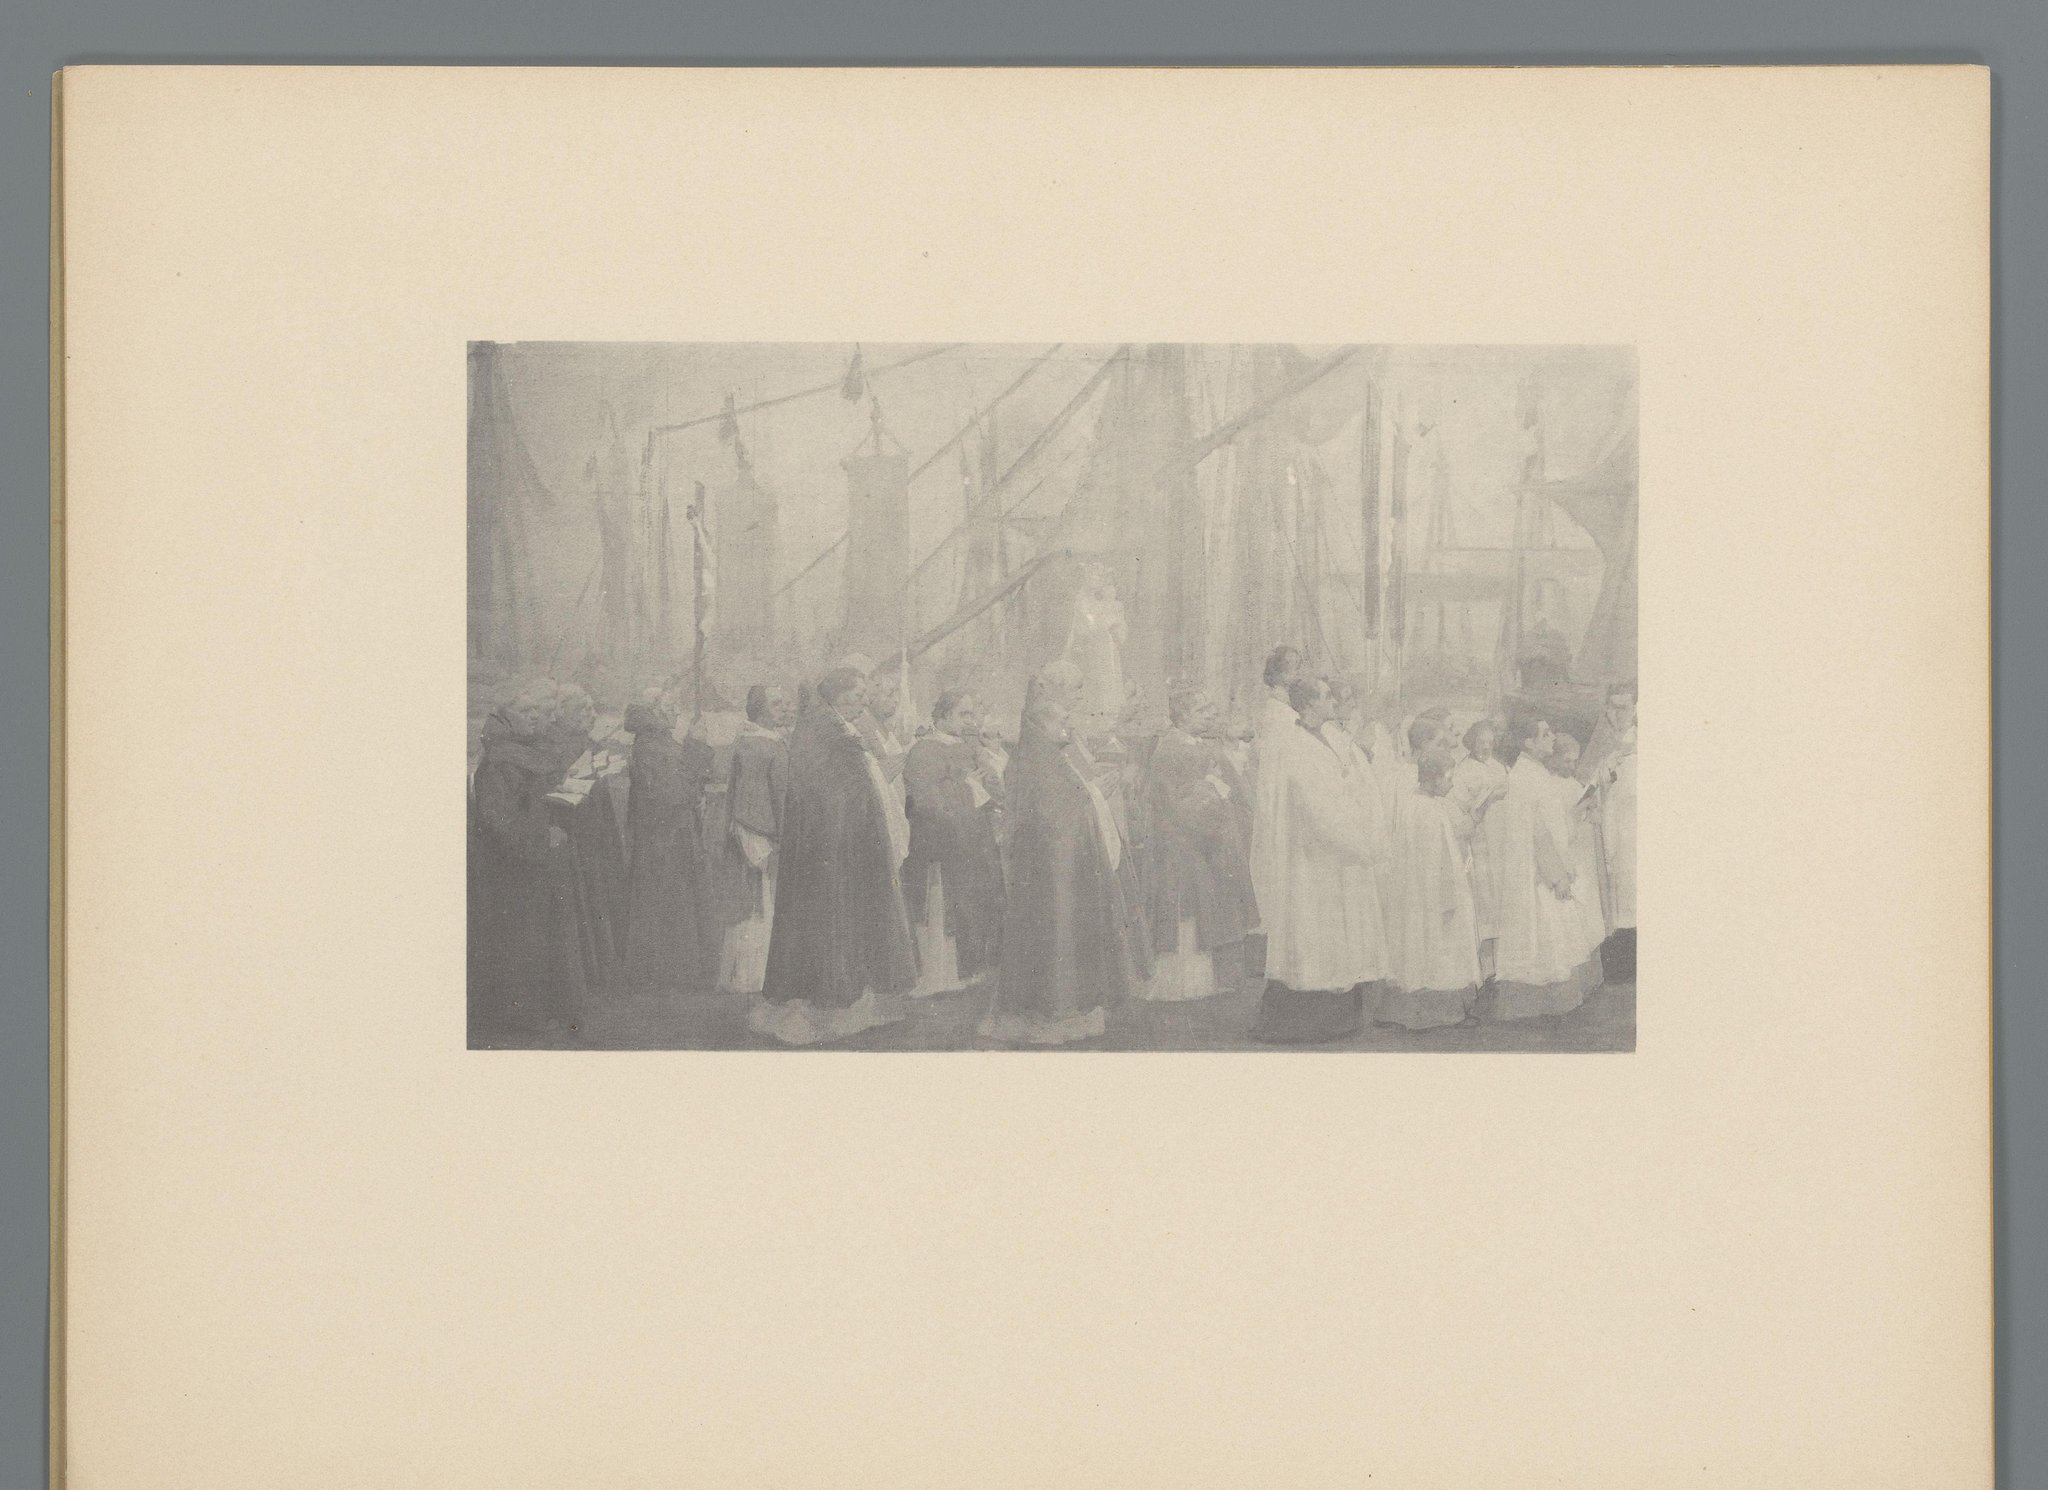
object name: photomechanical print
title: Wandschildering 'De Processie'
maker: antoon derkinderen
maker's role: draughtsman, painter, print maker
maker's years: 1859-1925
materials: paper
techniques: photograph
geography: haarlem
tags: mural painter, procession ~ christian religion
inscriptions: collector's mark: Lugt 2166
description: Prent uit: Maandschrift voor vercieringskunst 1 (1896), nr. 1/2, maart en april 1896.